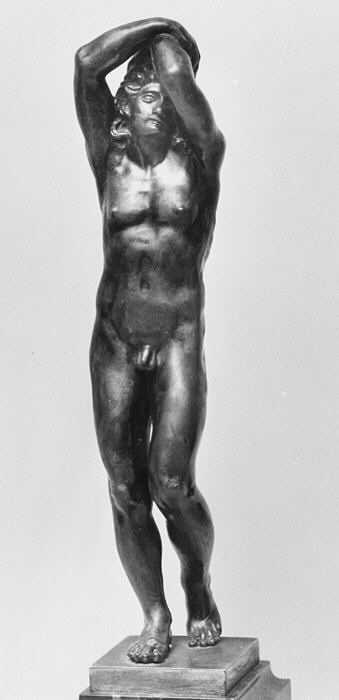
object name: statuette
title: Youth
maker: barthélemy prieur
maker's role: artist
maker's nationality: french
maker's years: 1536-1611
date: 1601-1700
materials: bronze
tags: male nudes